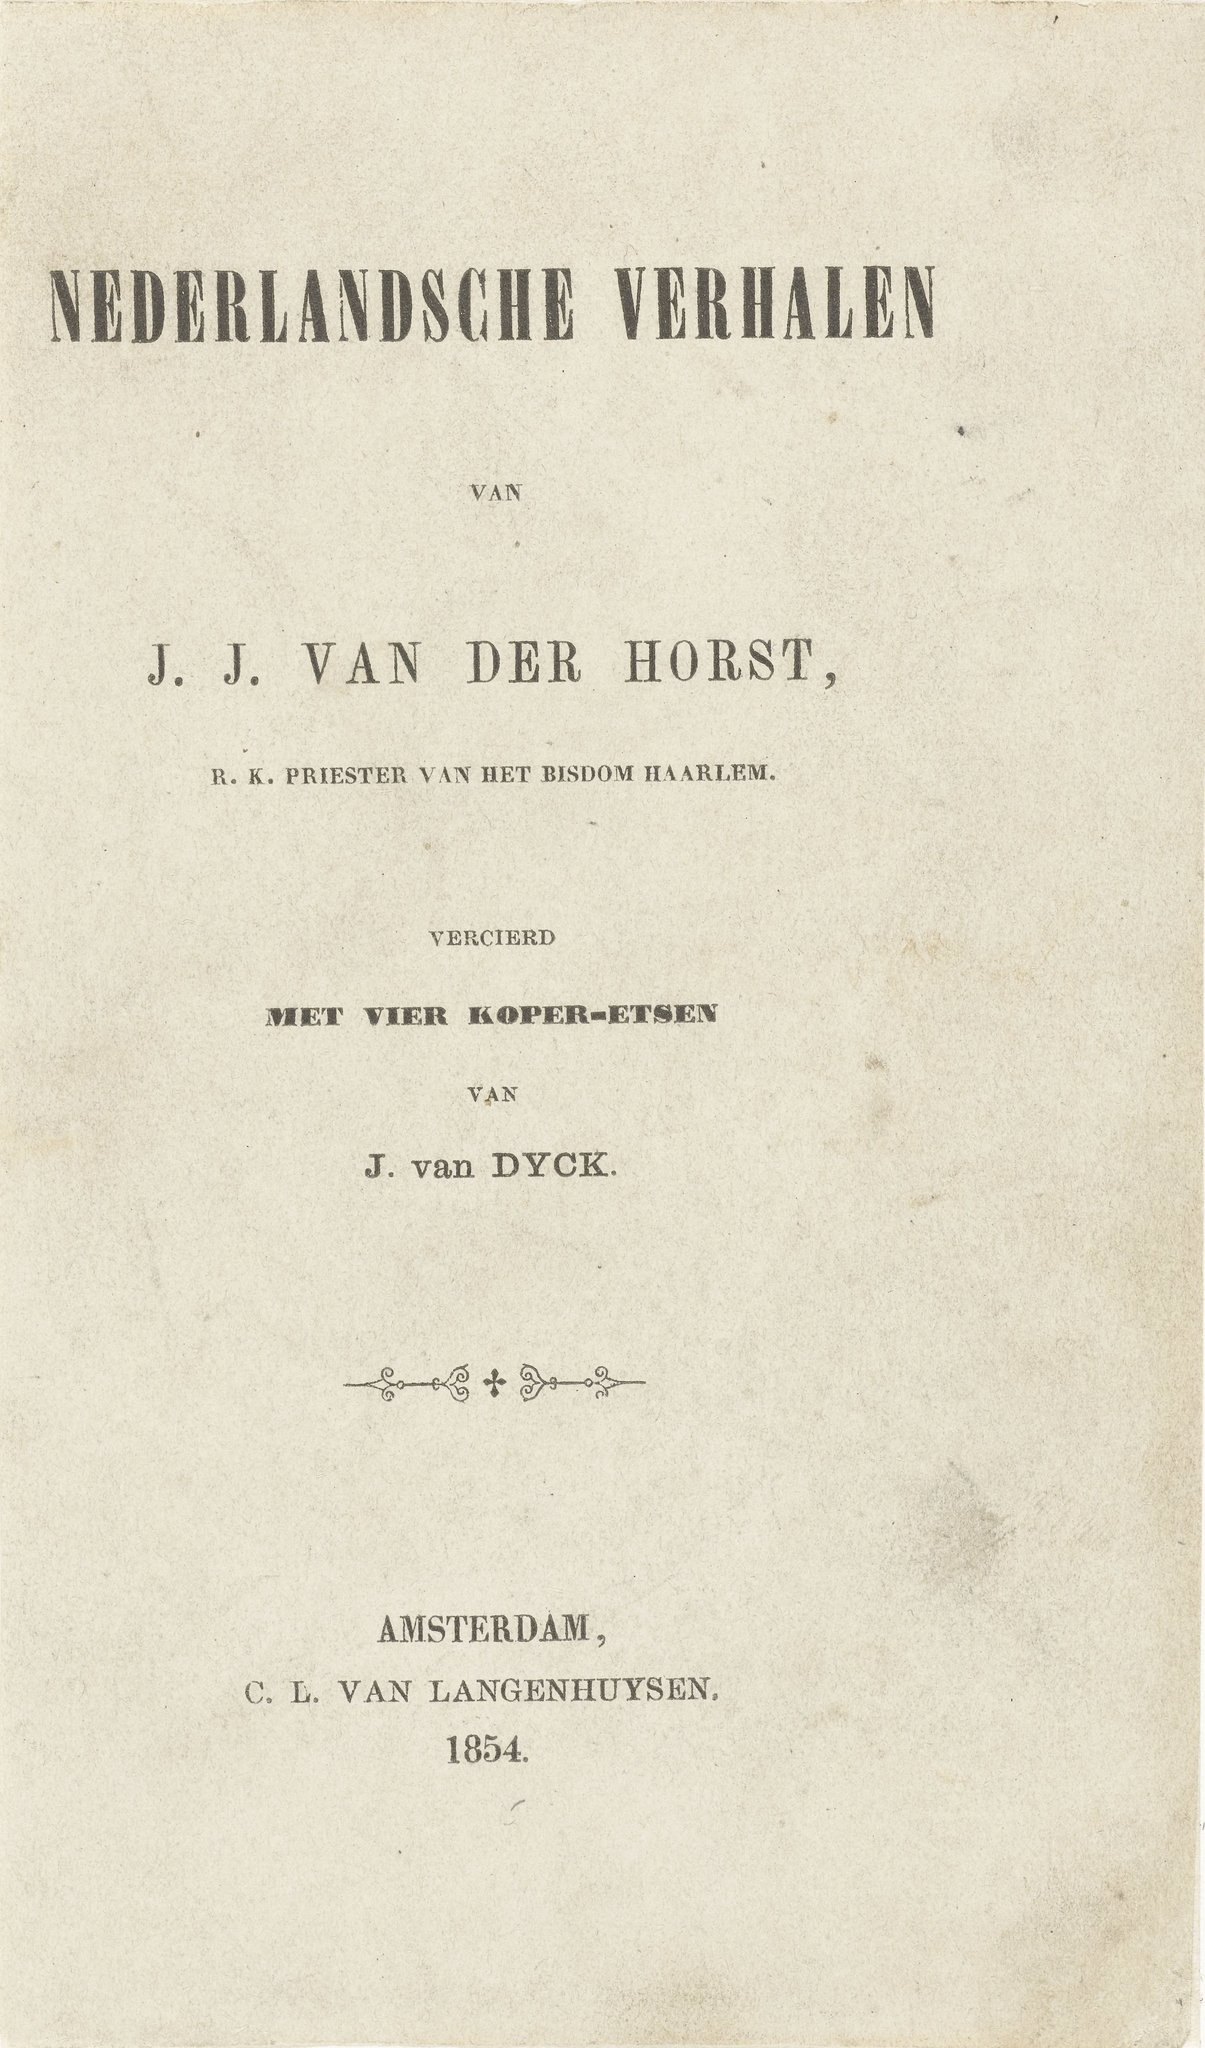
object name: titelblad, titelpagina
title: Titelpagina voor: J.J. van der Horst, Nederlandsche verhalen, 1854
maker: c.l. van langenhuysen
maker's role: publisher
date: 1854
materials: paper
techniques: letterpress printing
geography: amsterdam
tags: title-page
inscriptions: collector's mark: Lugt 2228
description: Titelpagina voor: J.J. van der Horst, Nederlandsche verhalen. Amsterdam: C.L. van Langenhuysen, 1854.